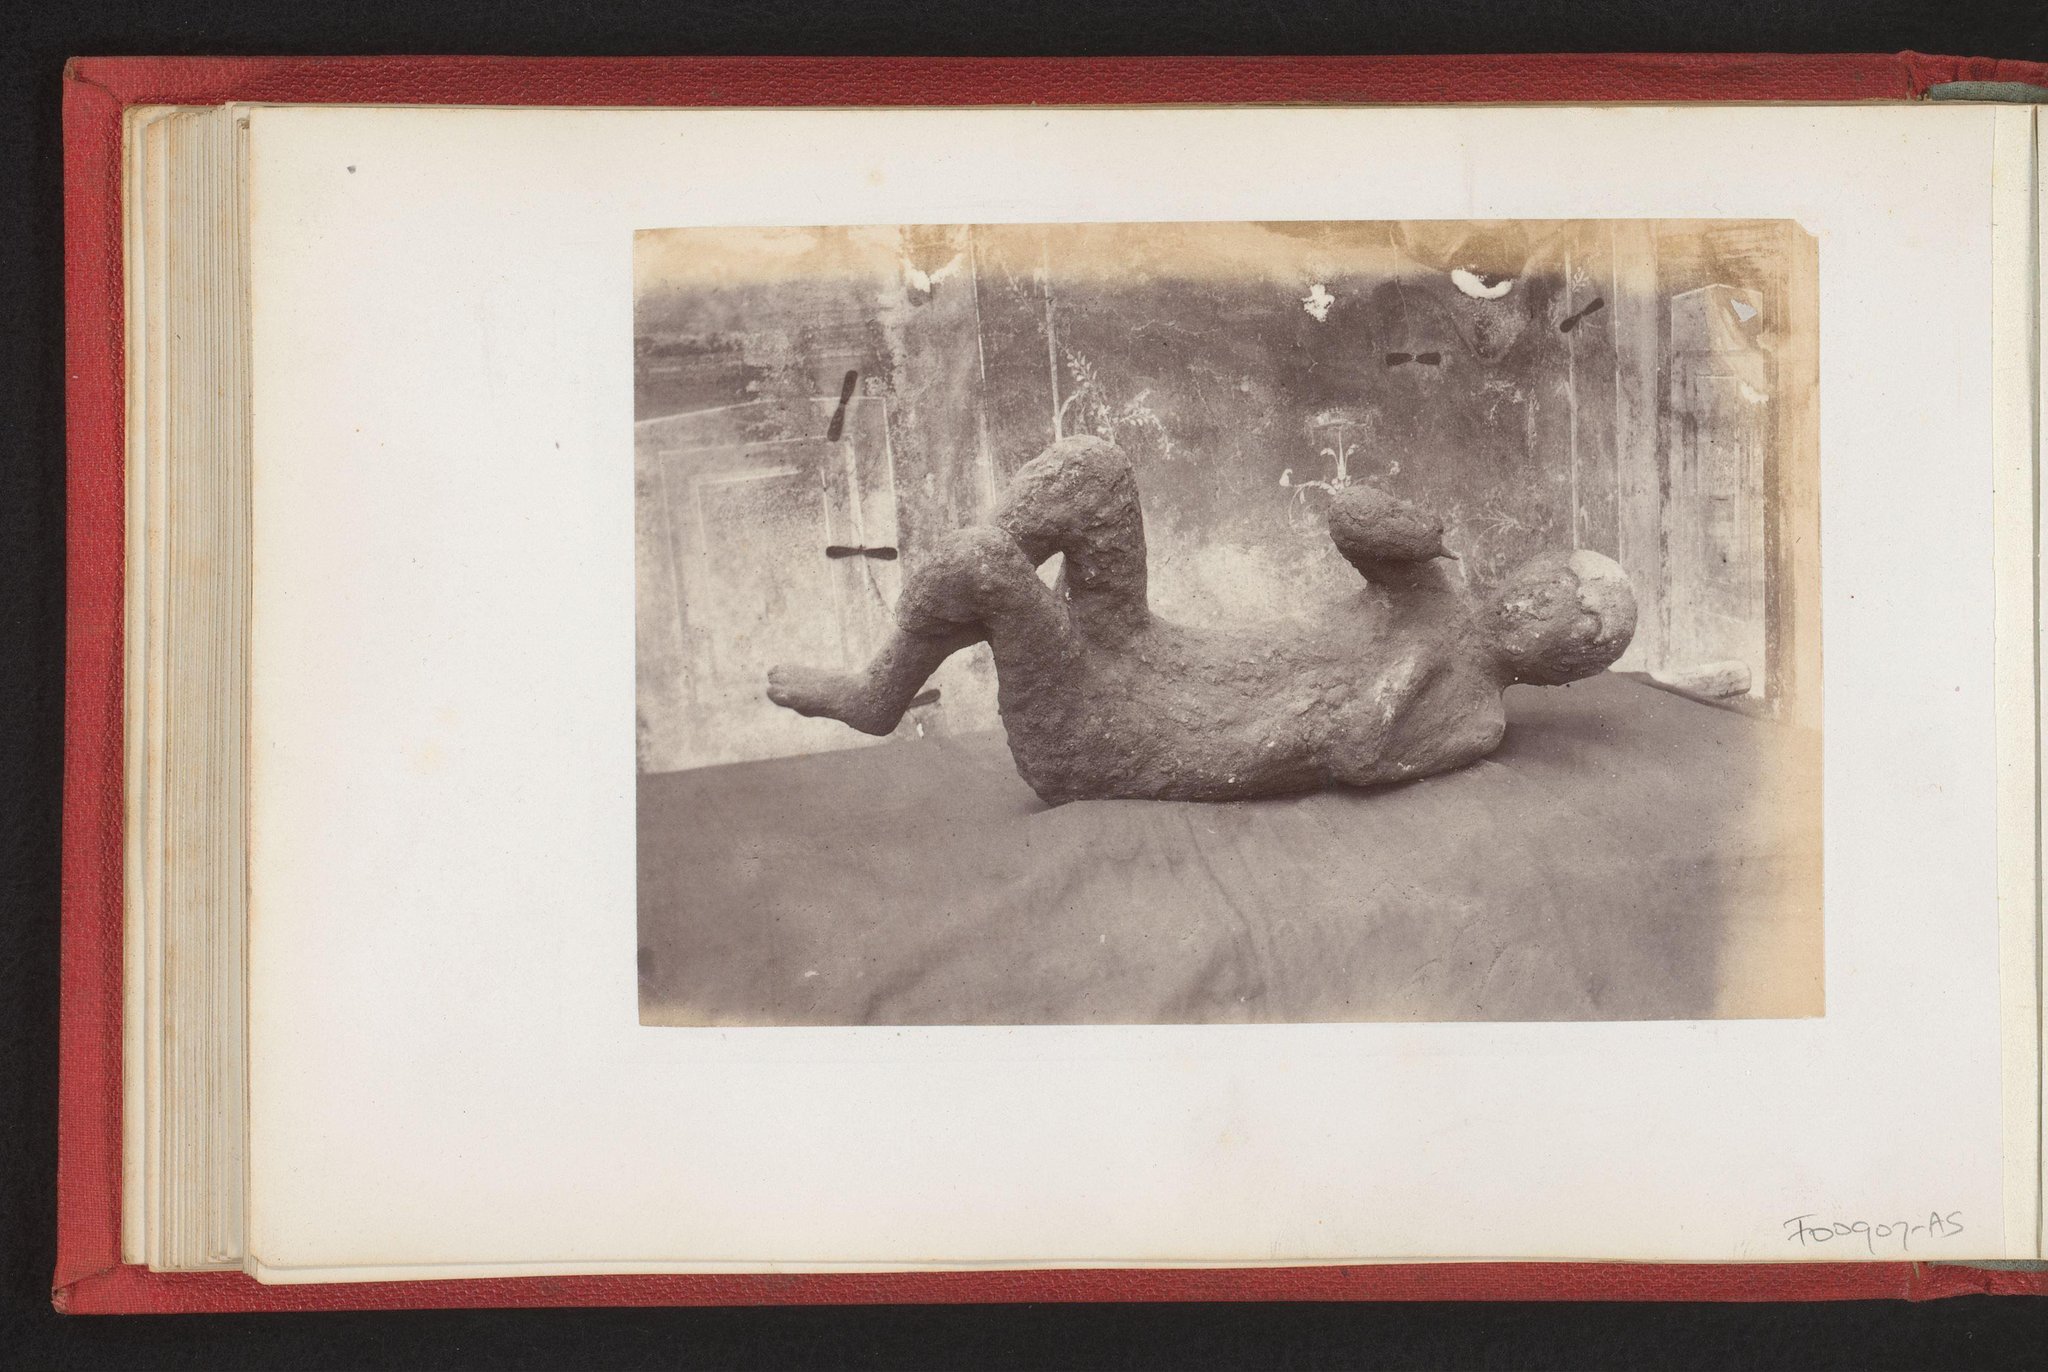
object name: photograph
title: Afgietsel van een slachtoffer van de uitbarsting van de Vesuvius in 79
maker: Anonymous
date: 1860-1900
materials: photographic support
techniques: albumen print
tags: death of human being, pompeii